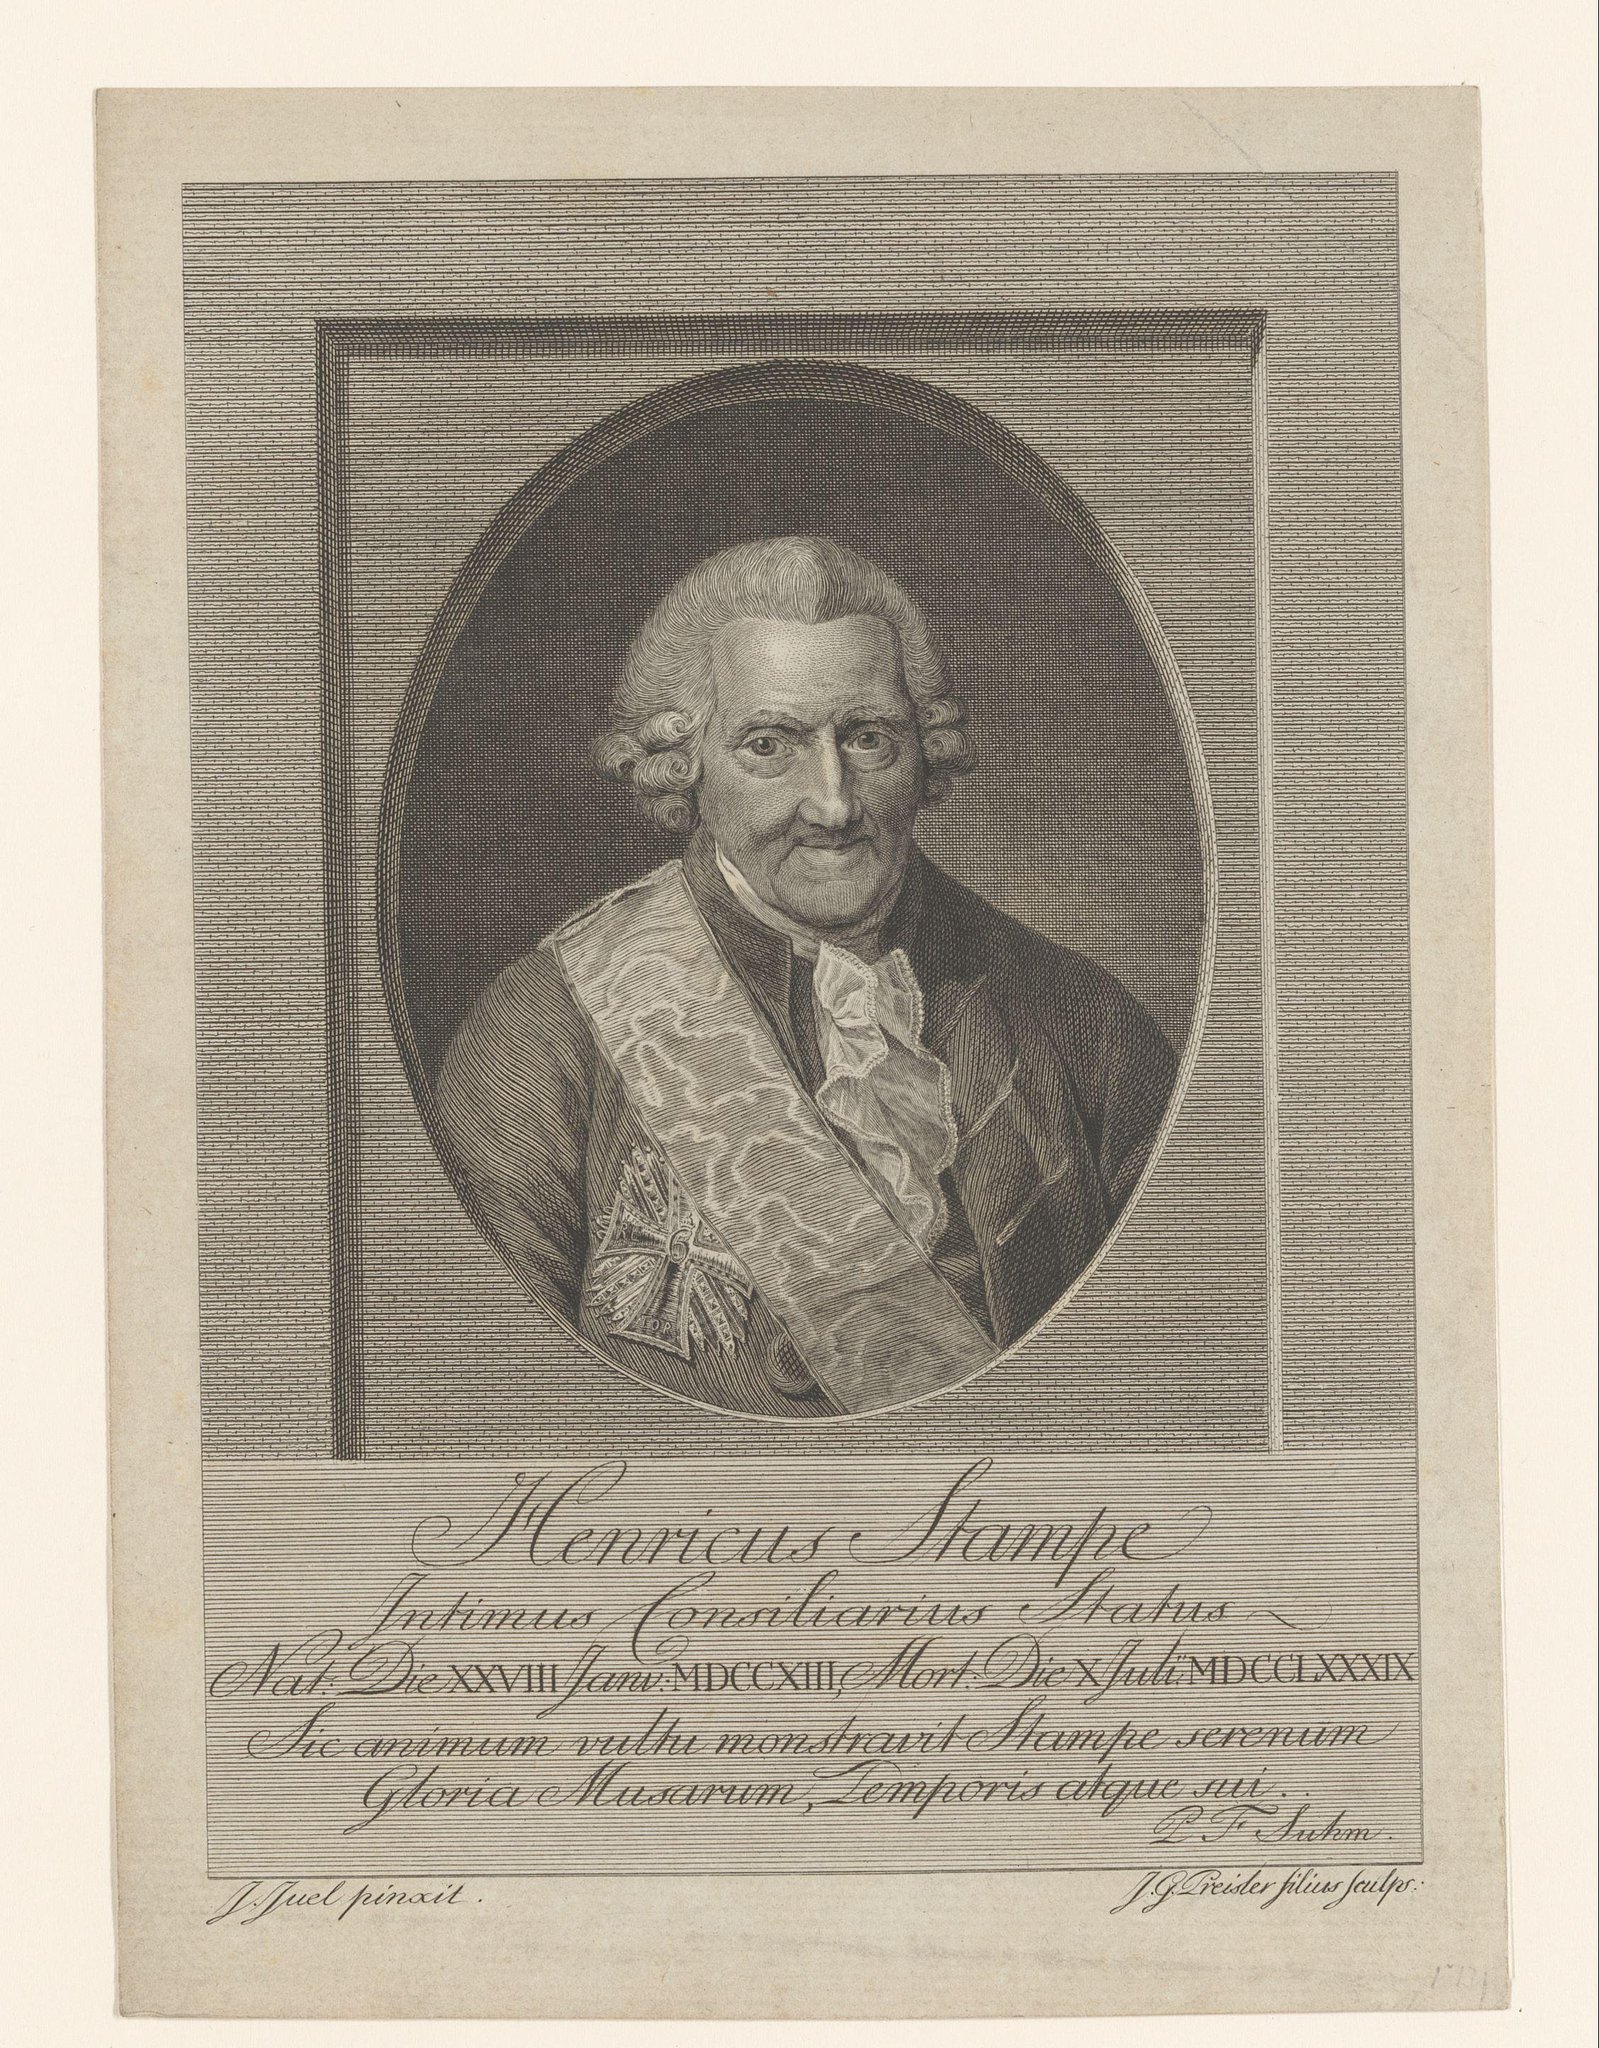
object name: print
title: Henricus Stampe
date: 1793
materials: paper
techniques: engraving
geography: denmark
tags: minister ~ government, historical persons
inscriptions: collector's mark: Lugt 2228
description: Portret van de Deense minister Henrik Stampe.